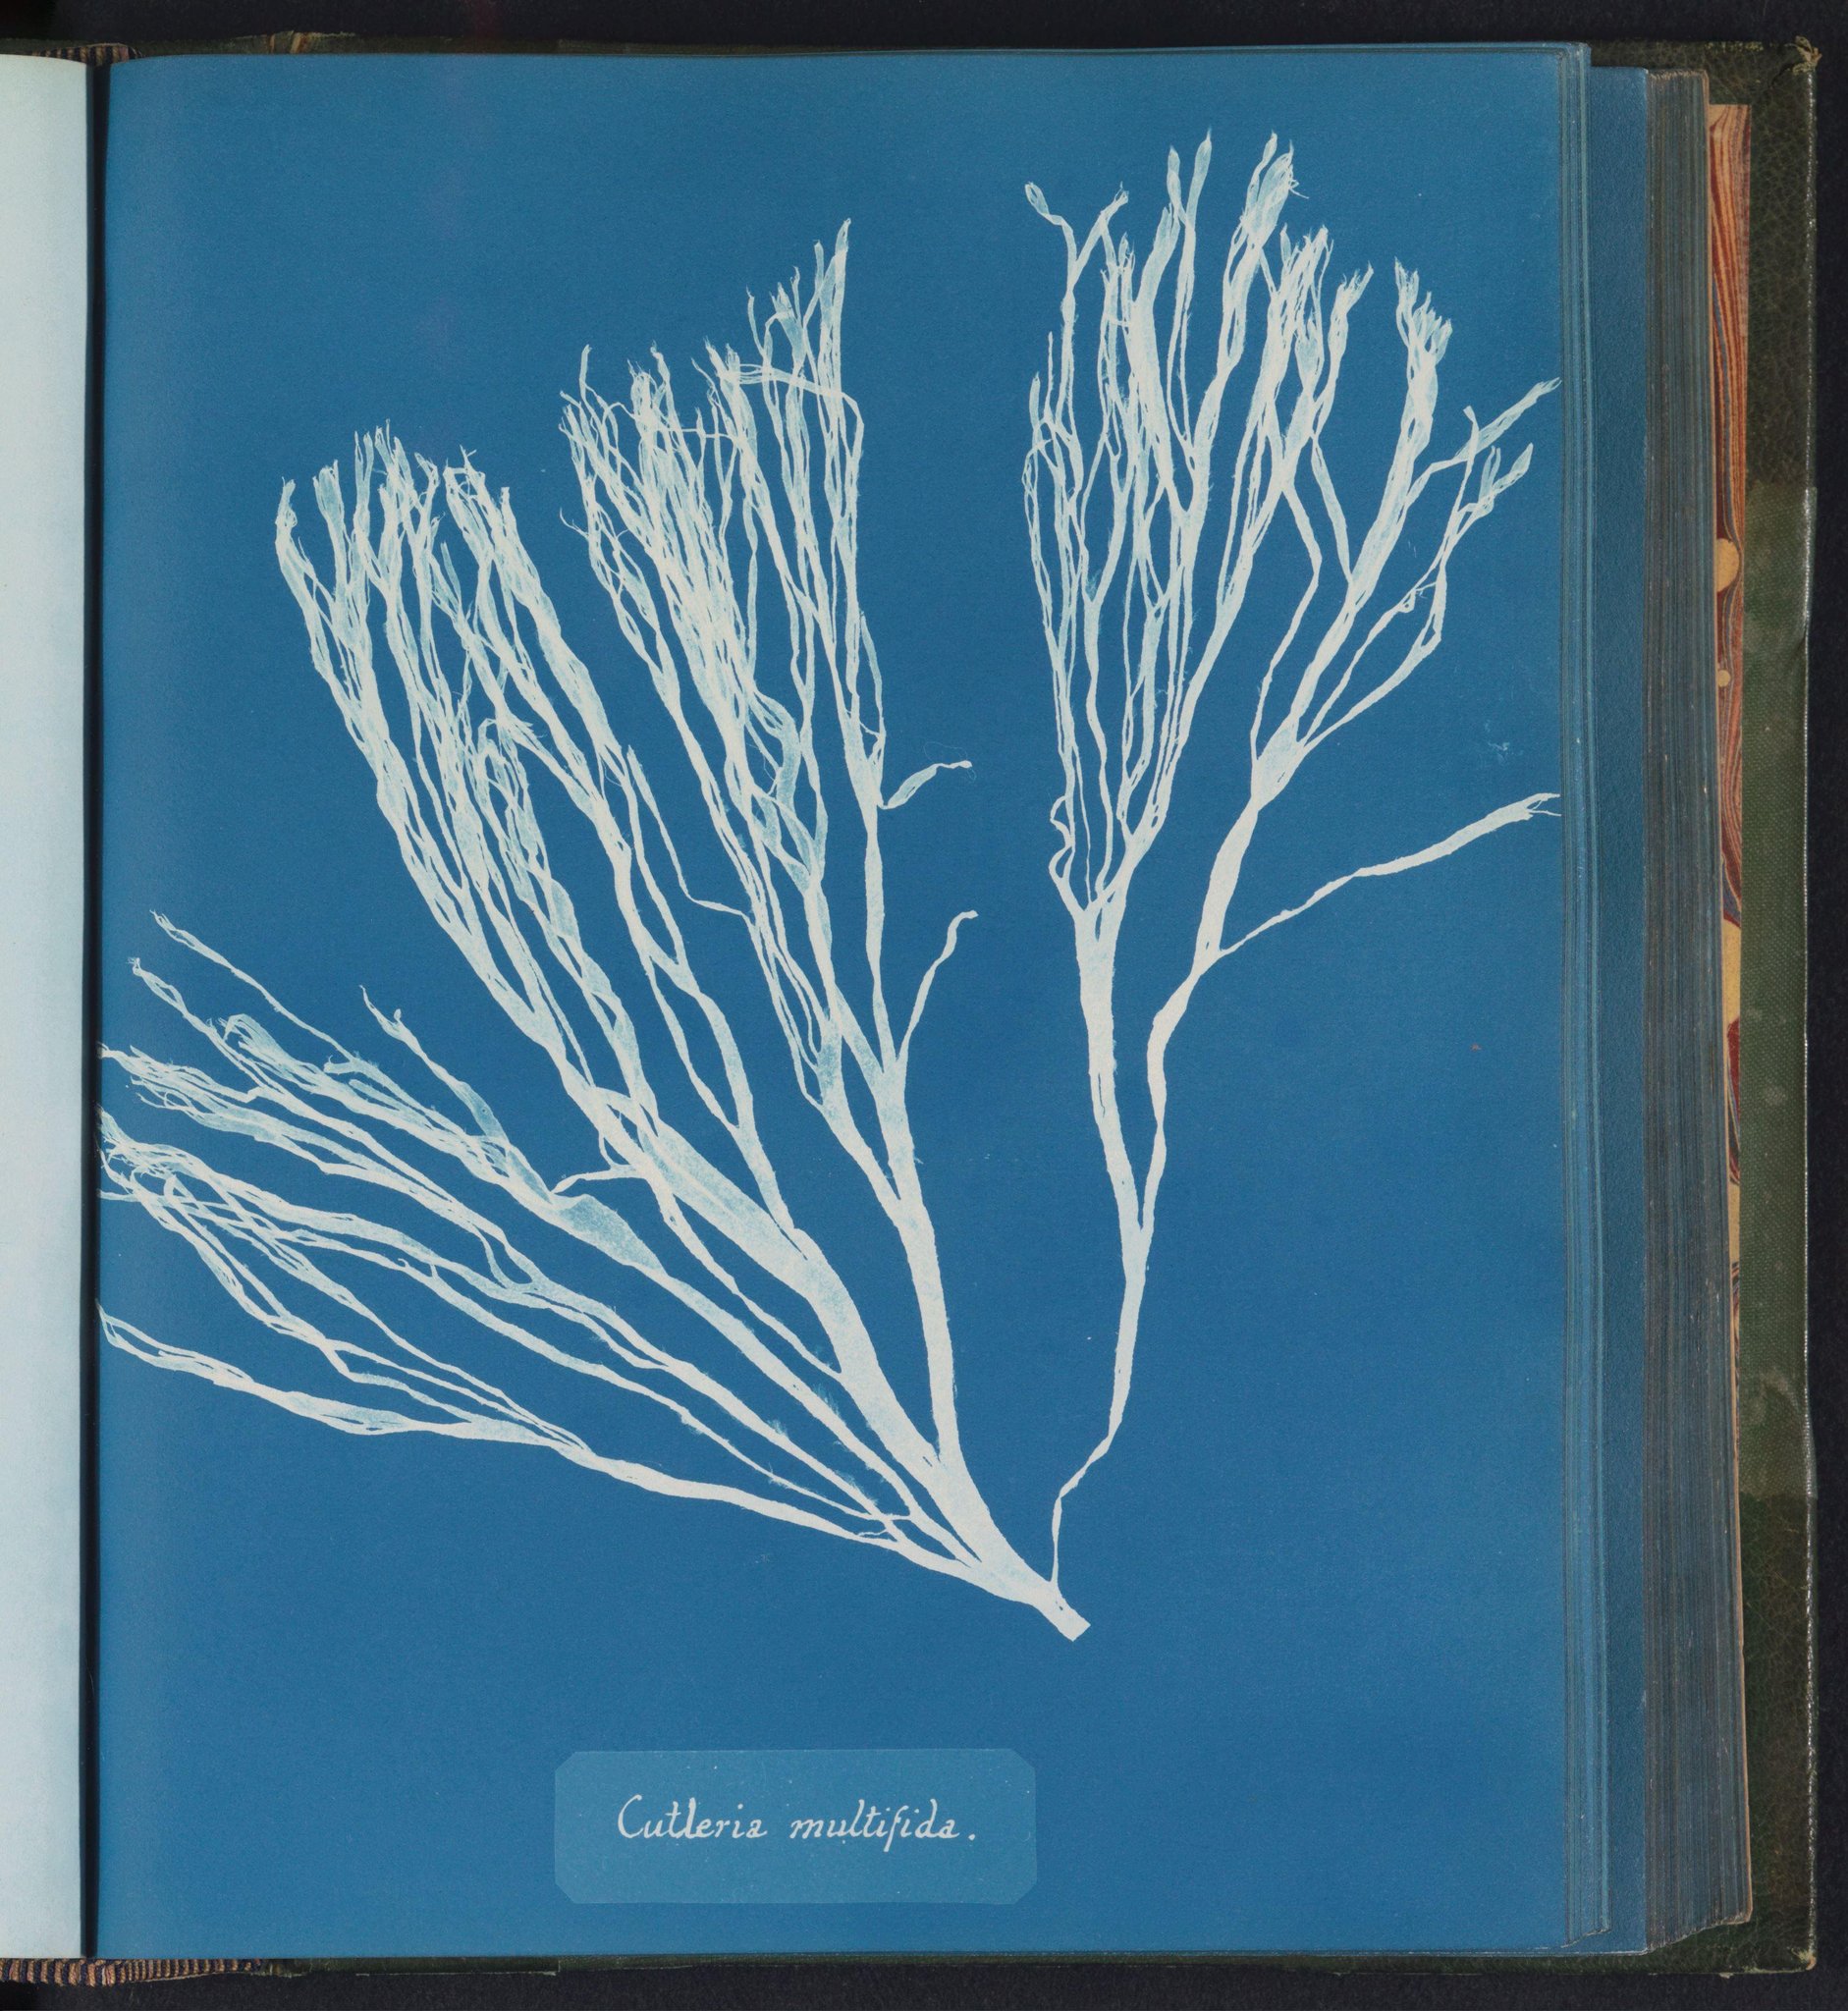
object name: photograph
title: Zeewier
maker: anna atkins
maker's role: fotograaf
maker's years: 1799-1871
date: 1843-1853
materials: photographic support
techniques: cyanotype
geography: united kingdom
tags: algae, seaweed